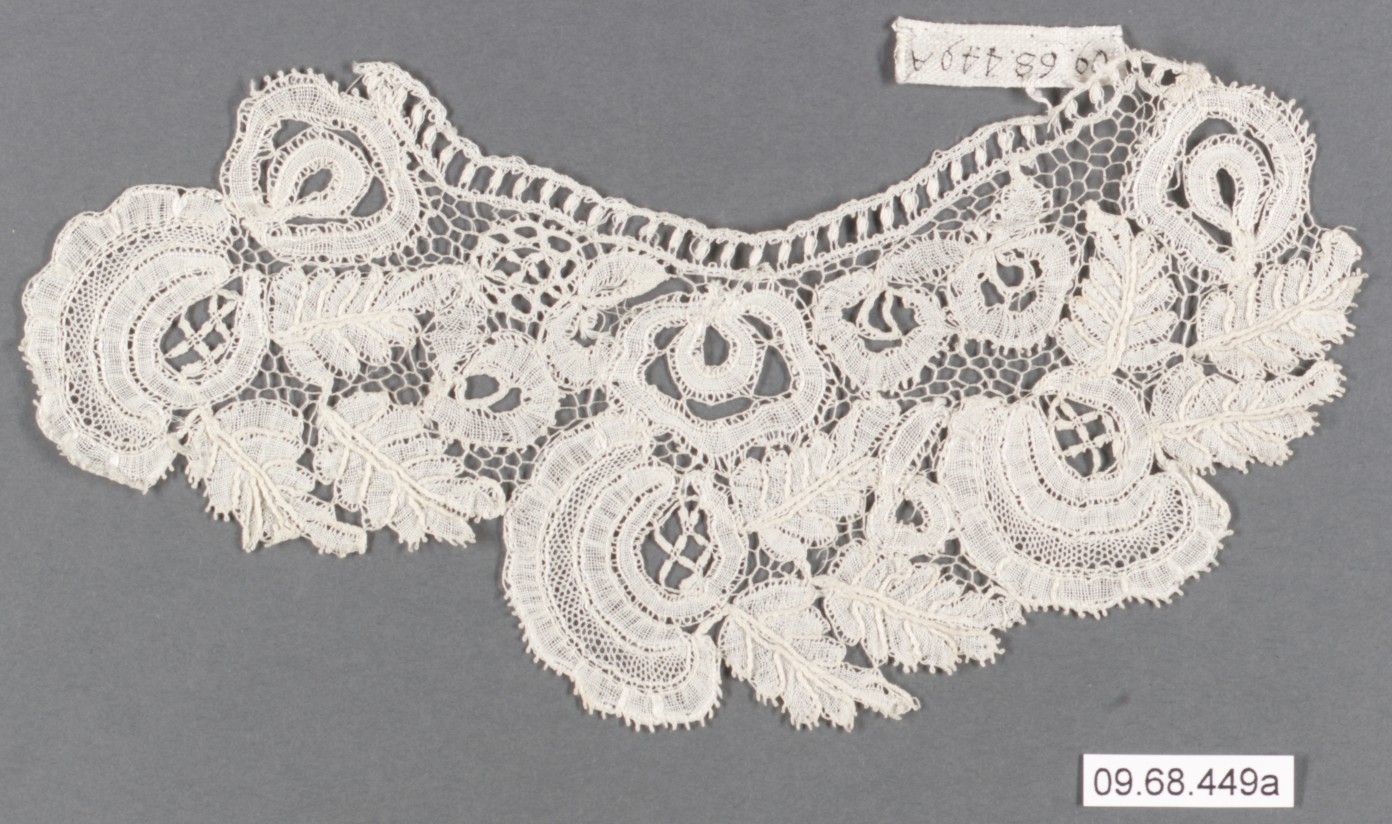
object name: cuff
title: Pair of cuffs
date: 1801-1900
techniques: lace